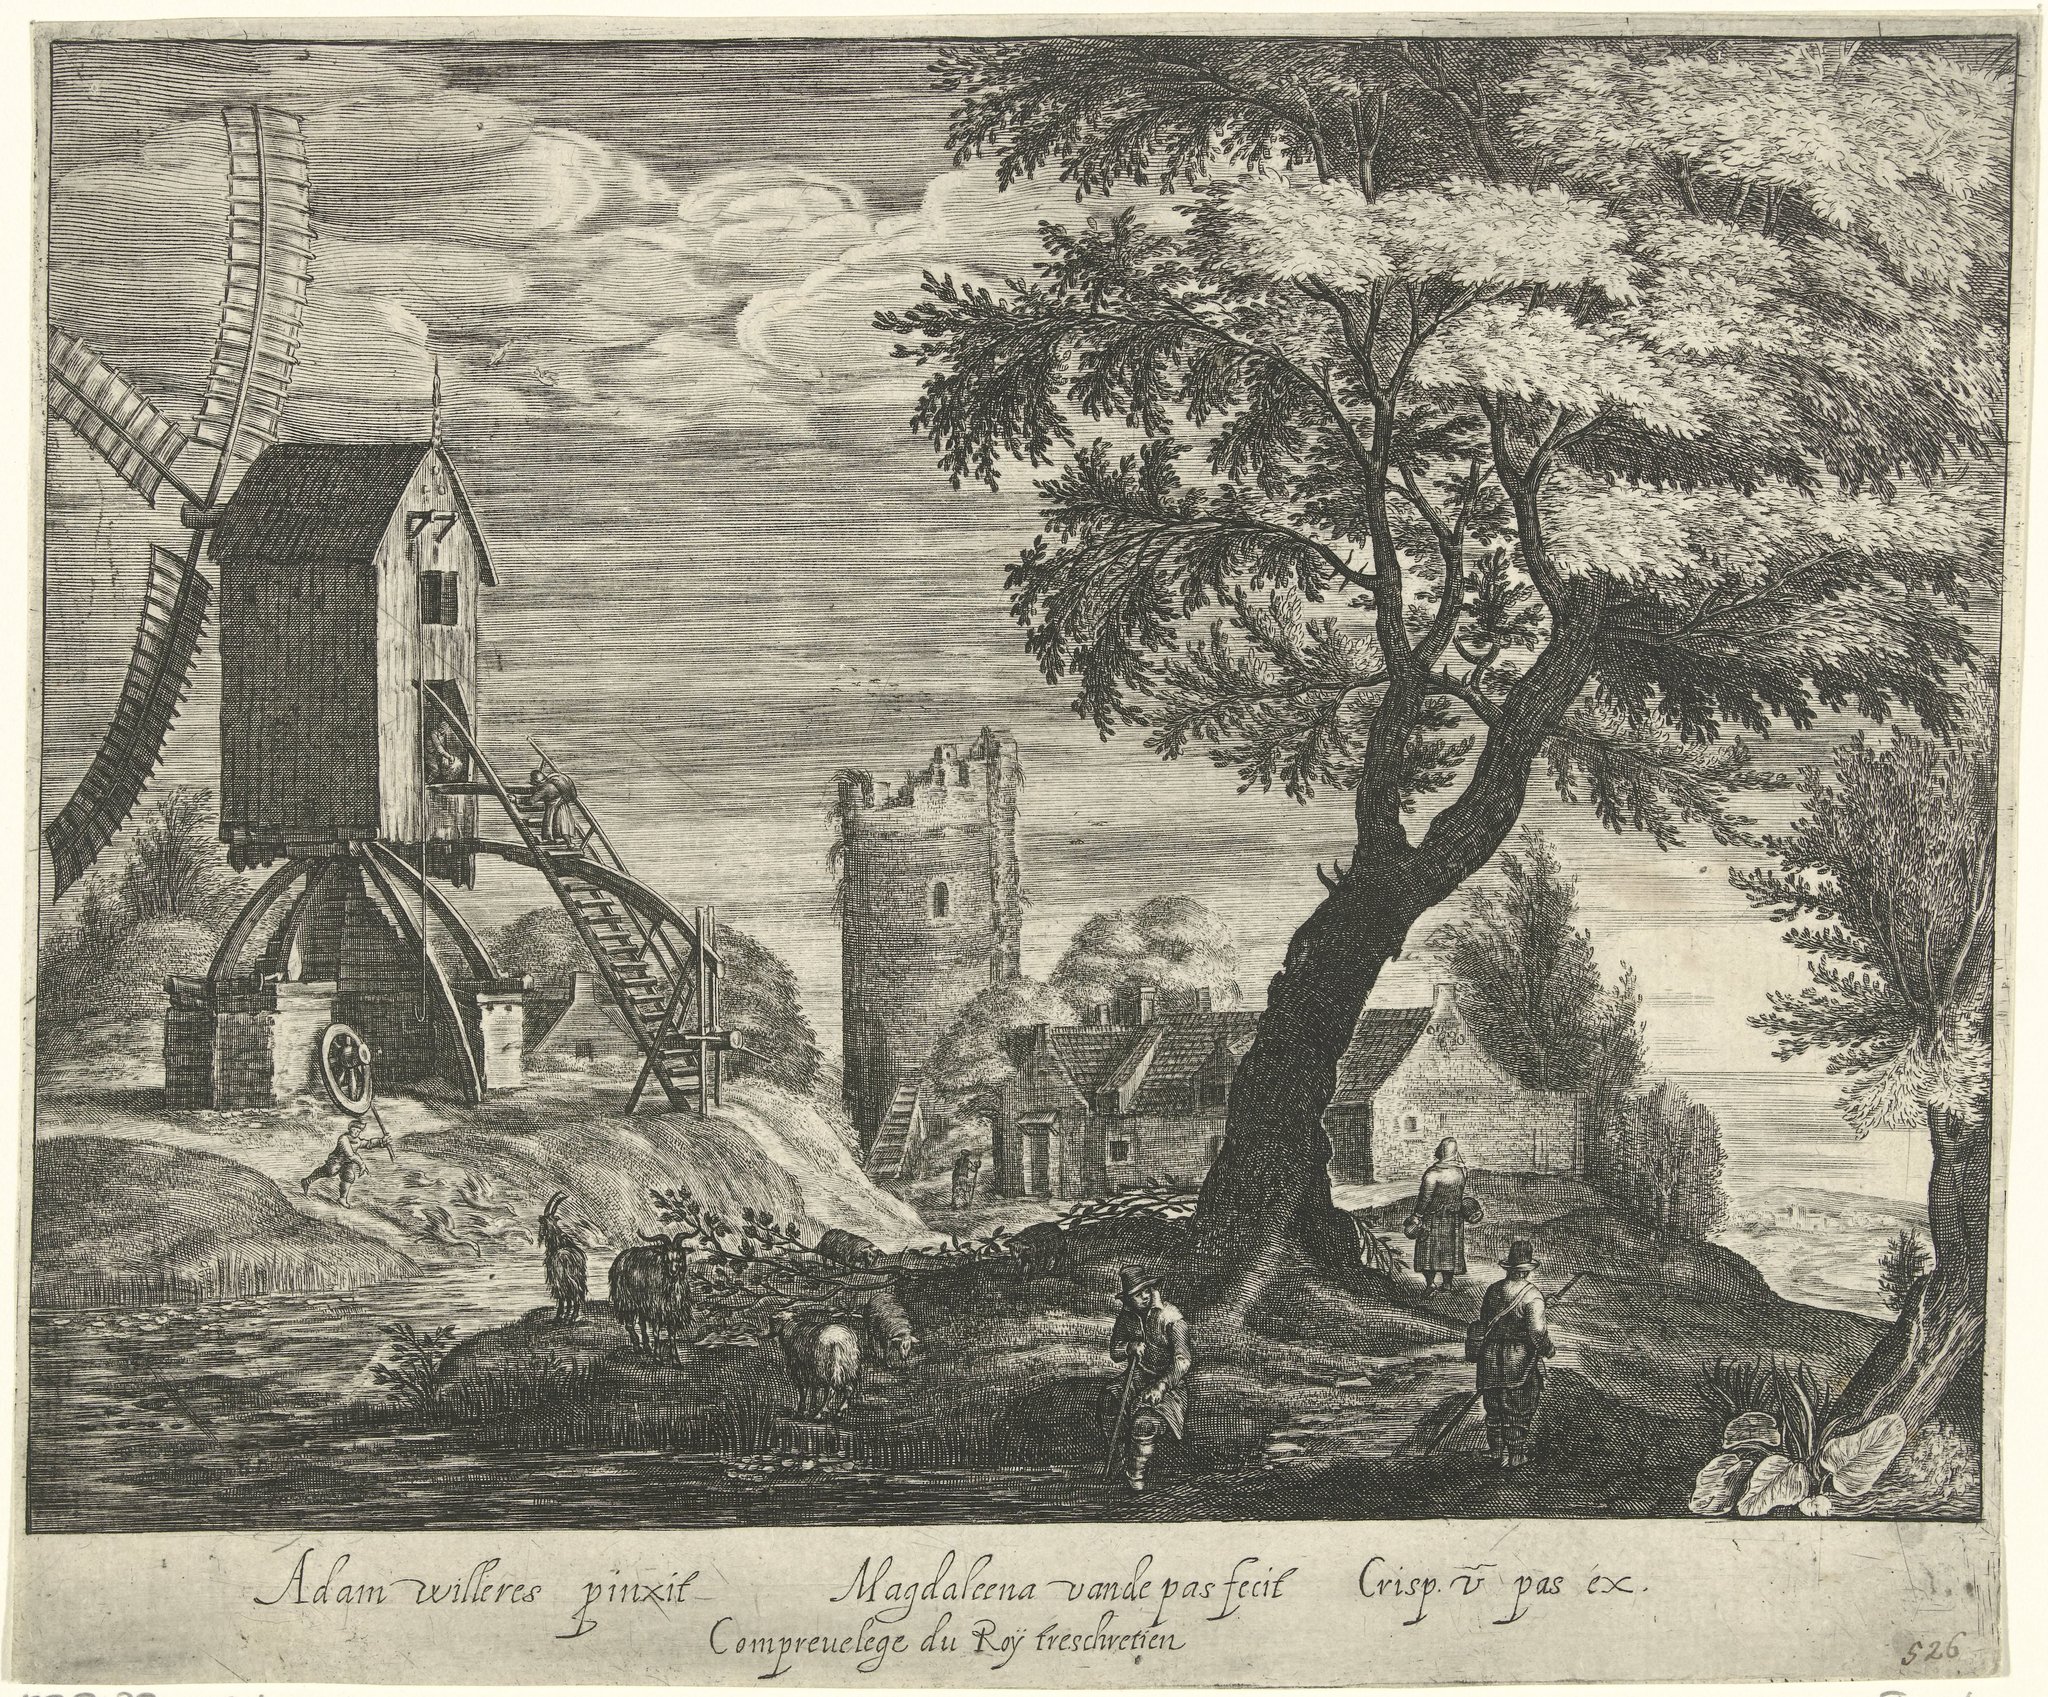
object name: print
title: Landschap met molen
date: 1617-1634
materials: paper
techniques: engraving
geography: utrecht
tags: windmill in landscape, landscapes (+ landscape with figures, staffage)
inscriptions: number: ‘526’, collector's mark: Lugt 240, number: ‘106’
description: Landschap met een molen en op de voorgrond een herder met zijn kudde.